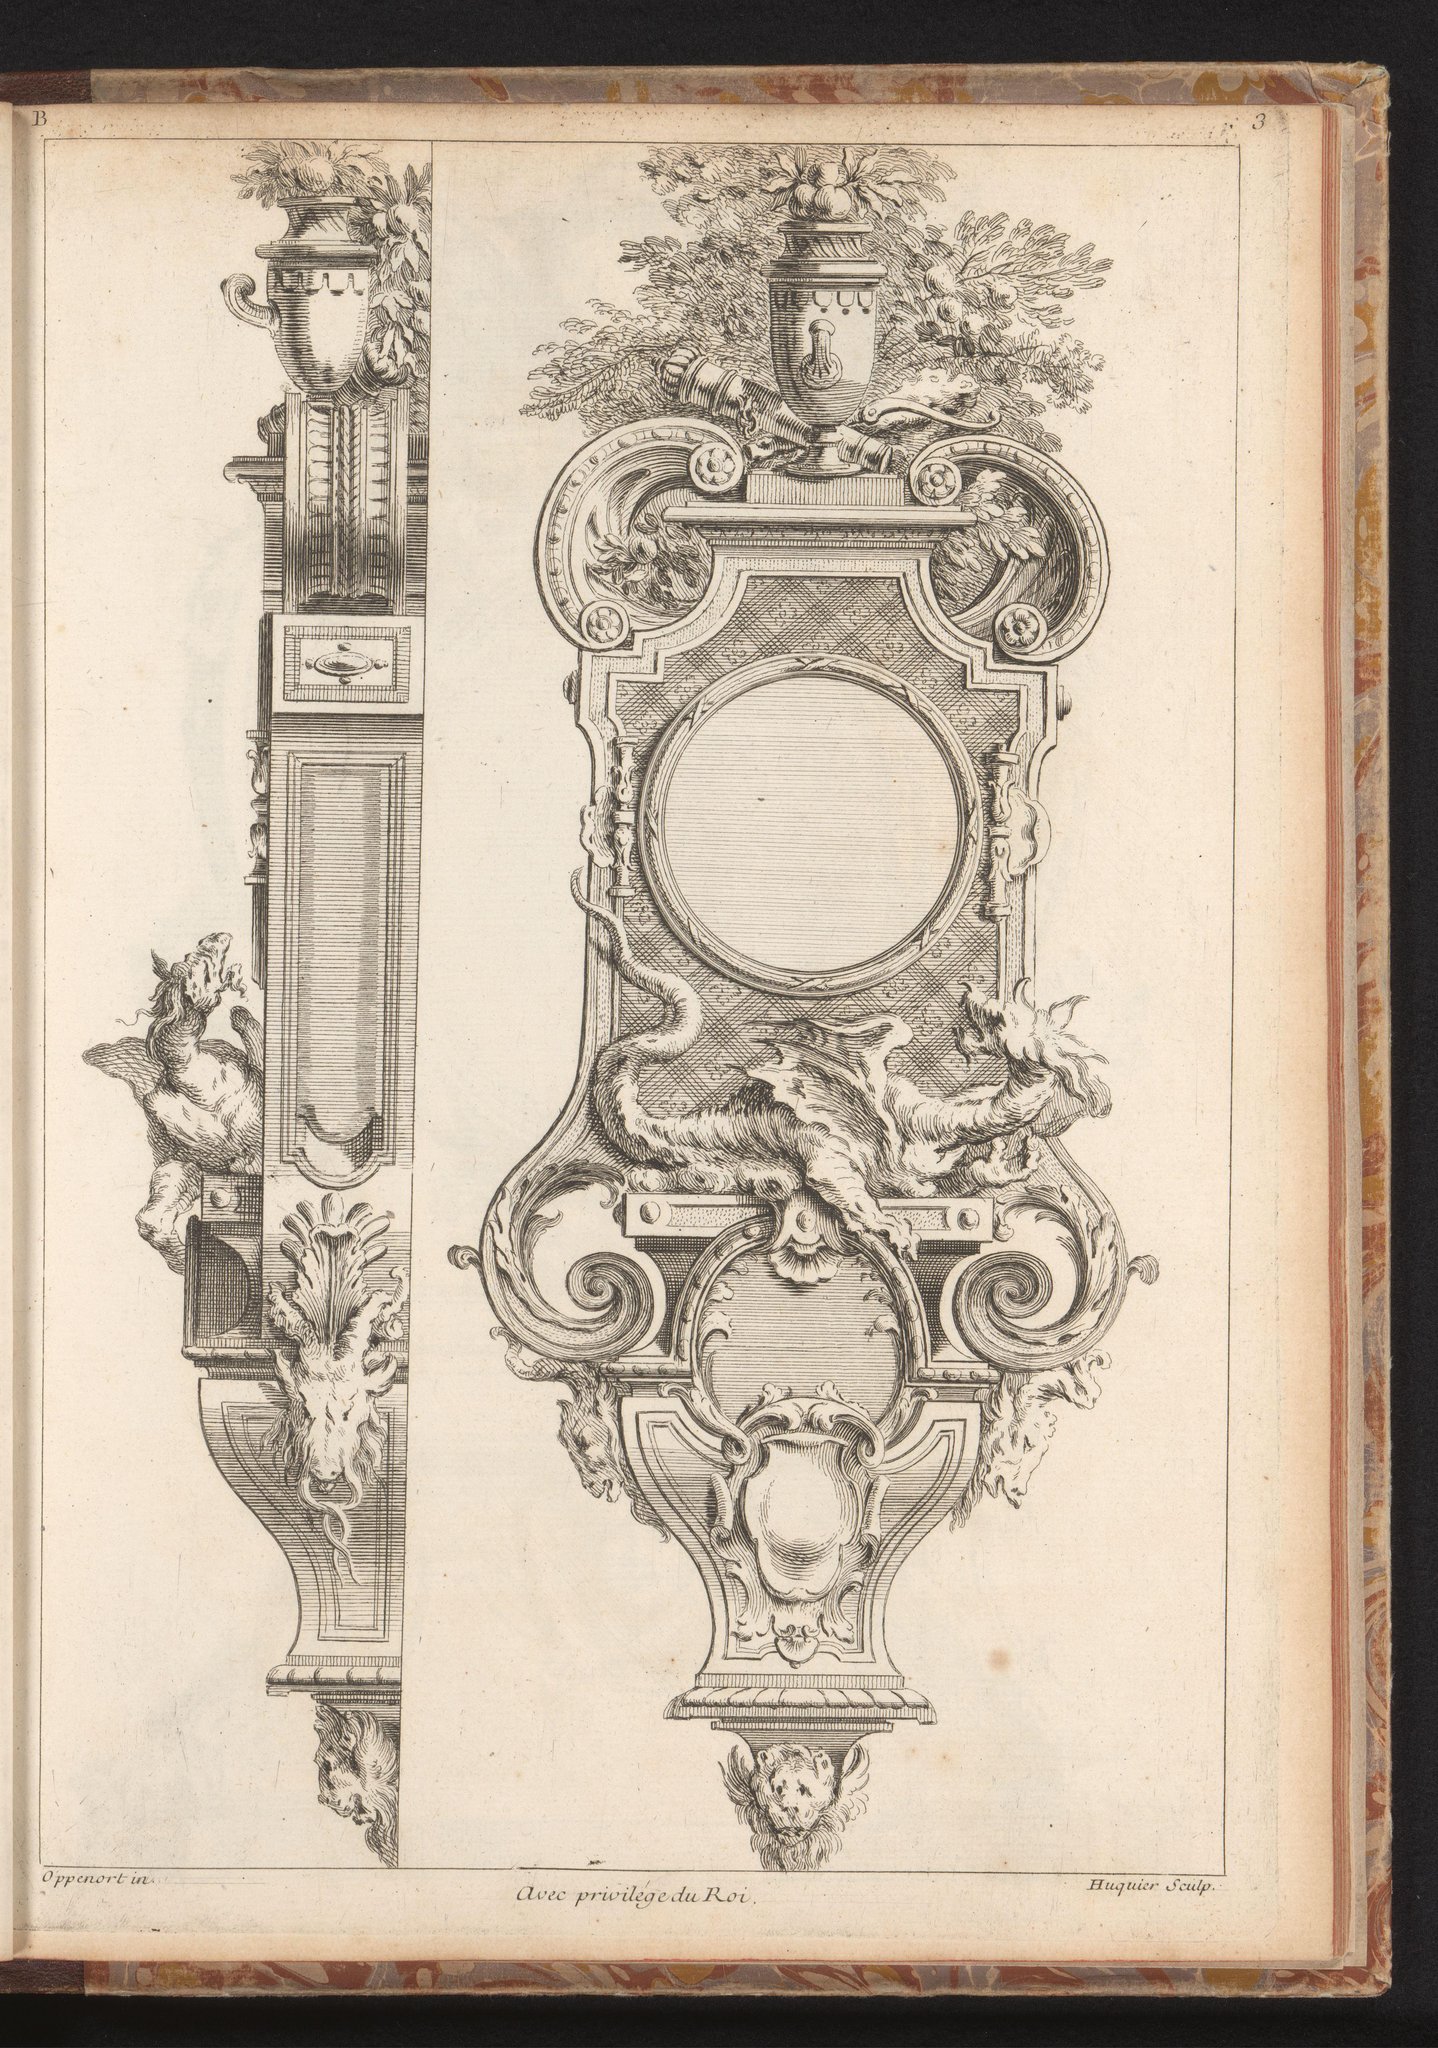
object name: album leaf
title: Diverse ontwerpen voor klokken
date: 1725-1750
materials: paper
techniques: etching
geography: paris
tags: ornaments ~ art, clock, dragon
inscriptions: collector's mark: Lugt 2228a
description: Deze prent maakt deel uit van een album.